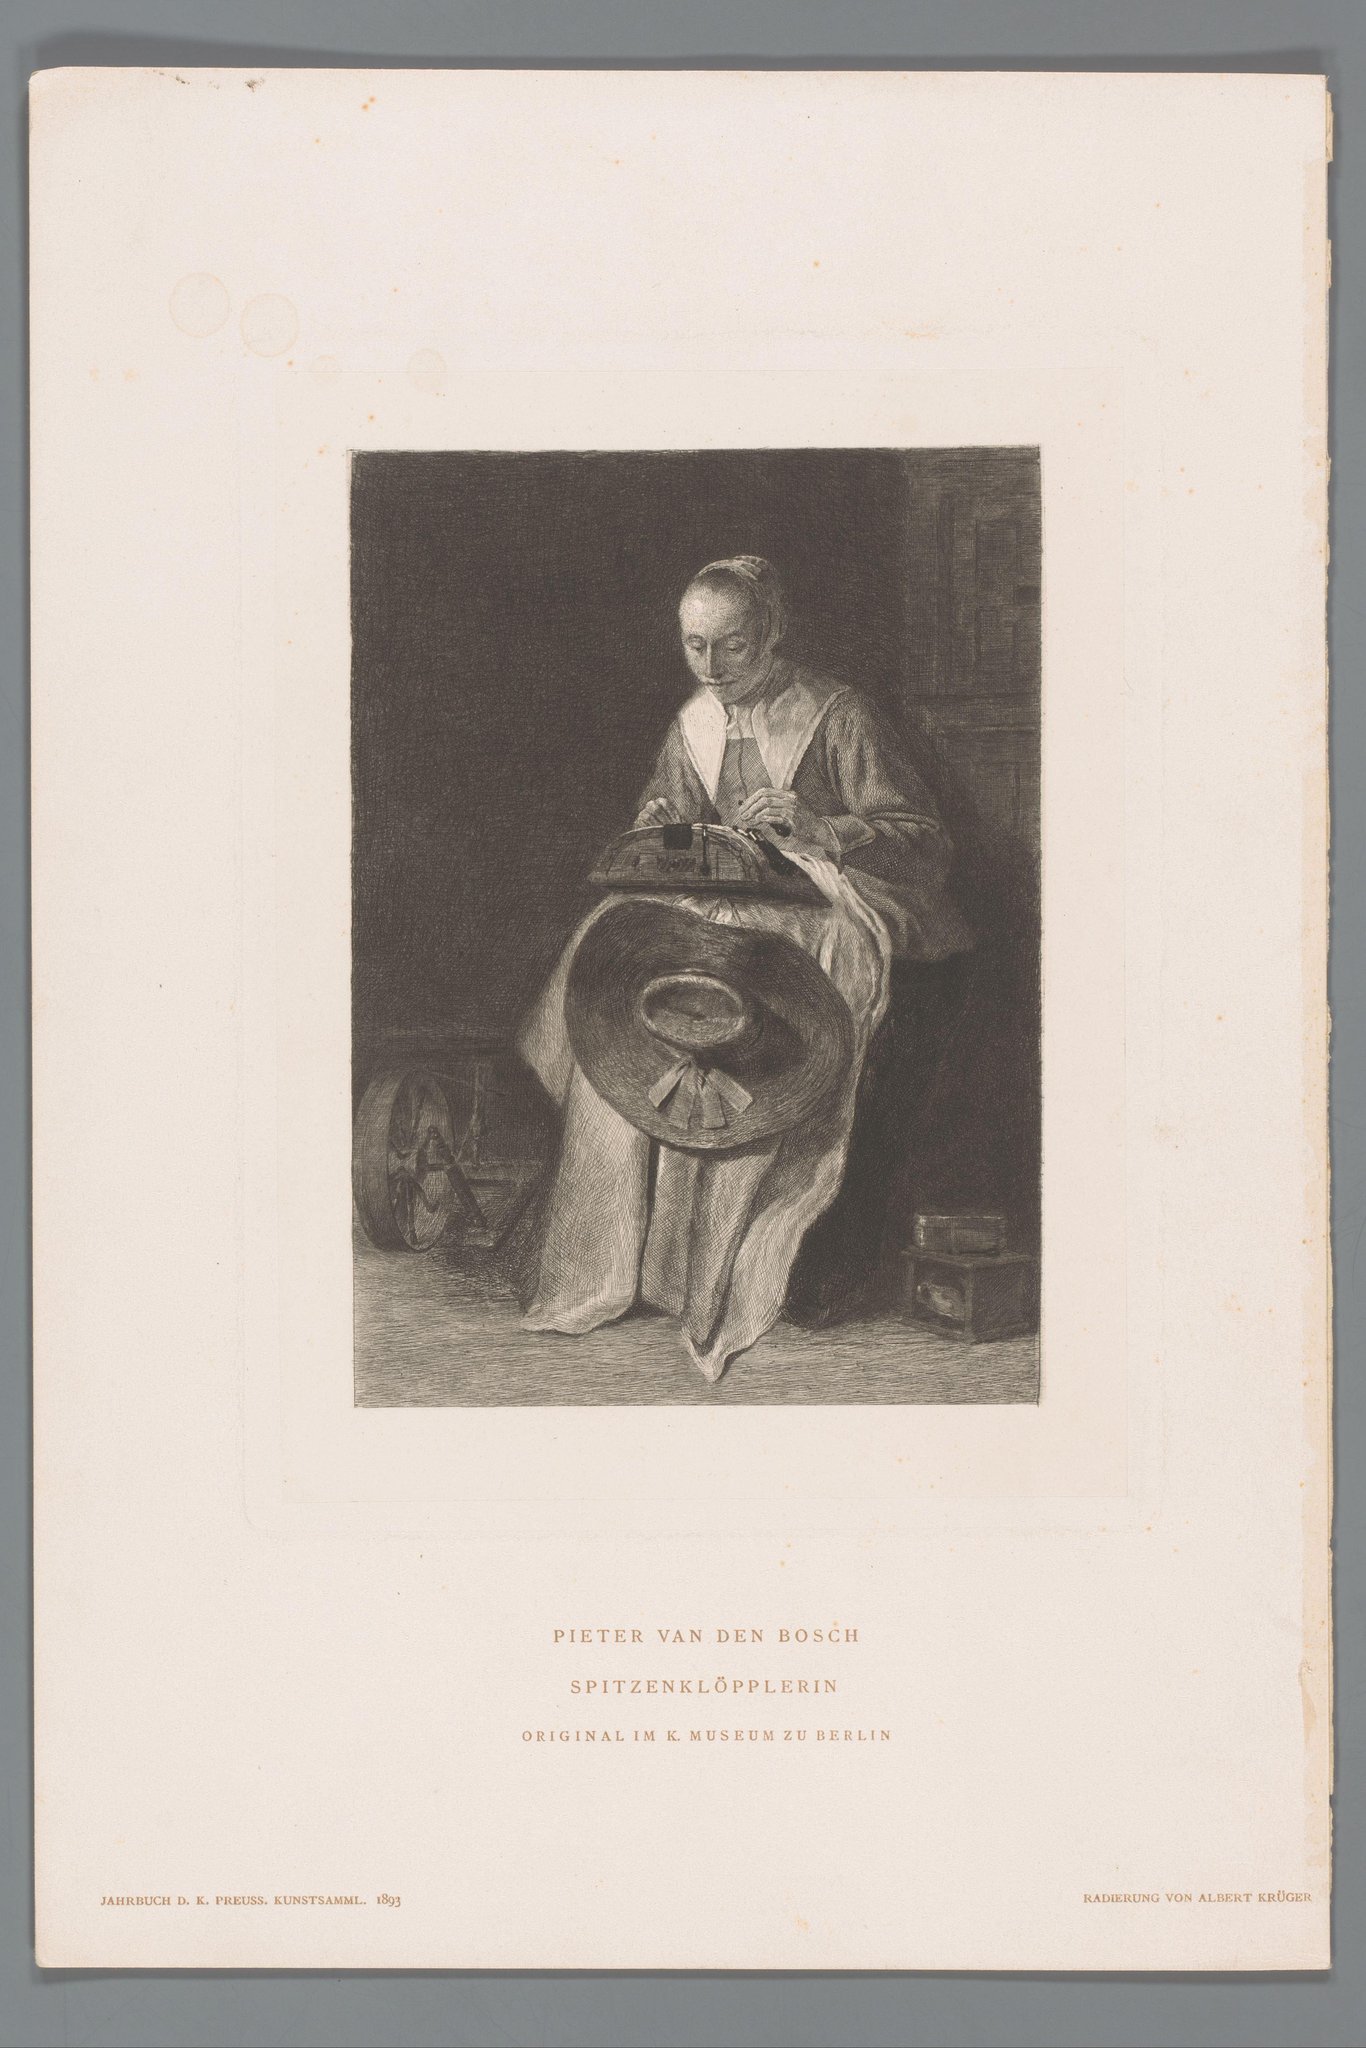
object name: print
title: Spitzenklöpplerin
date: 1893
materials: paper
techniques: drypoint, etching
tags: lace-making, old woman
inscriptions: collector's mark: Lugt 2228